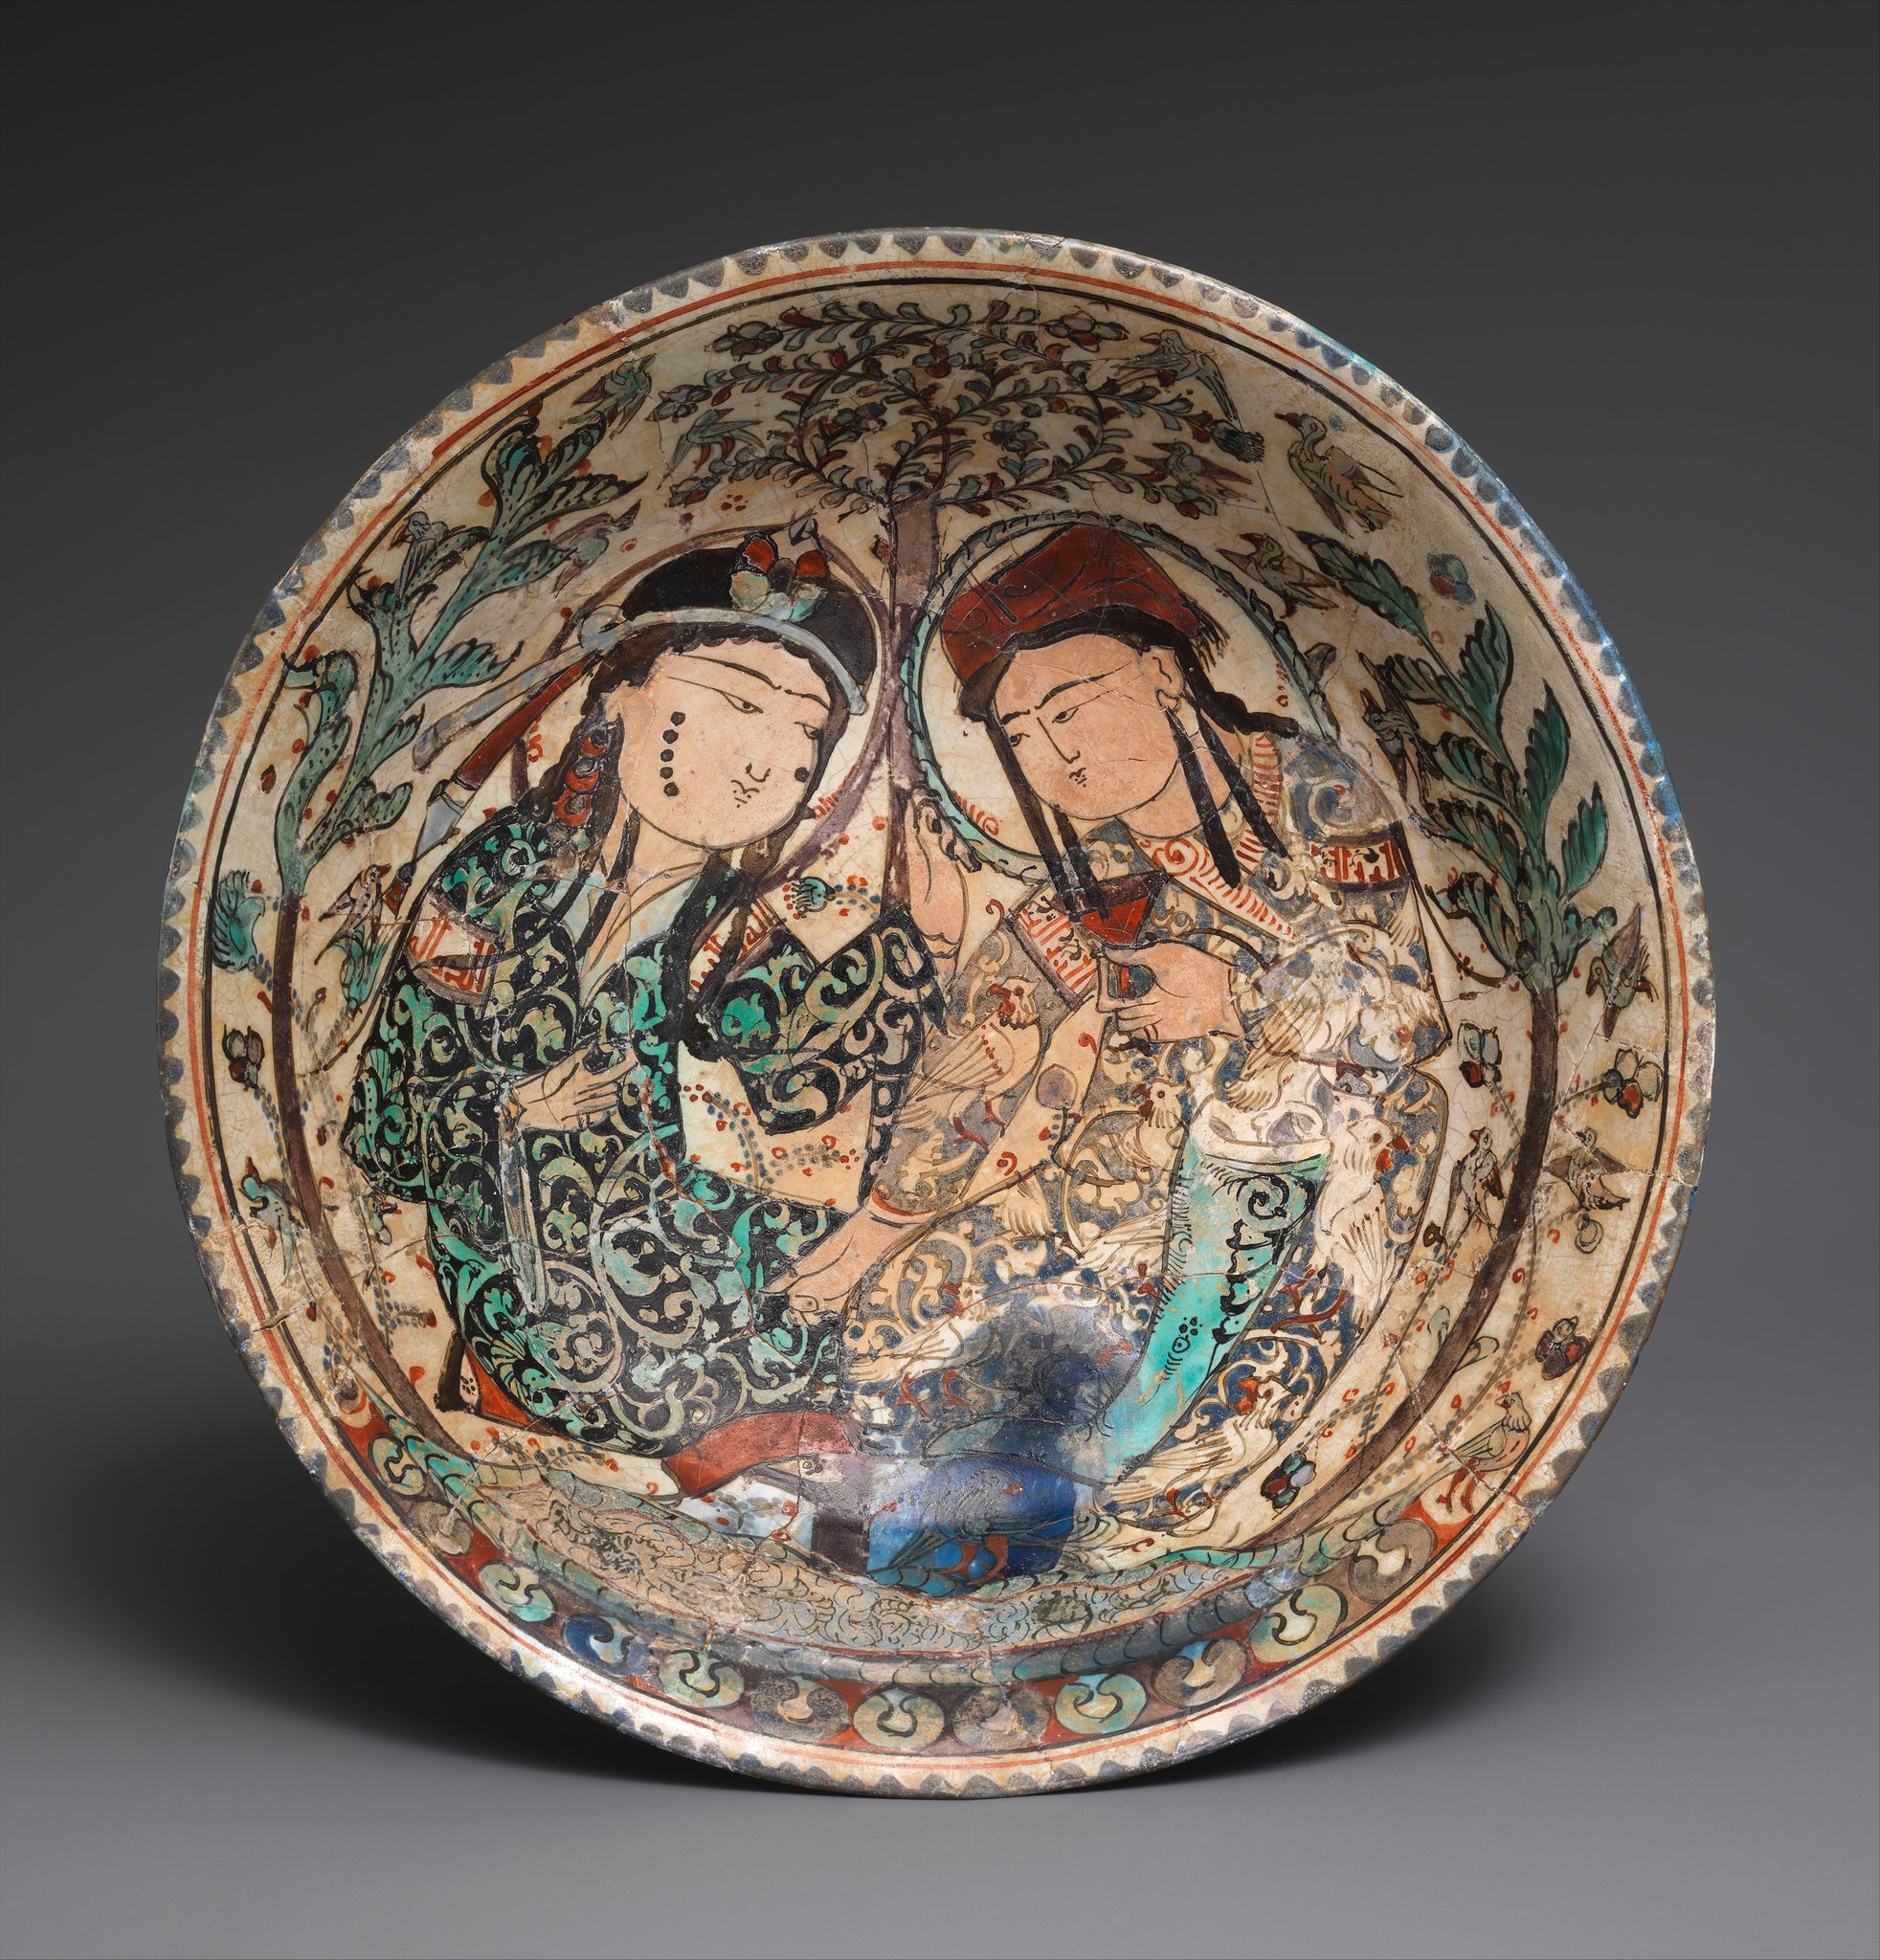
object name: bowl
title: Bowl, Mina'i ("enameled") ware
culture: iranian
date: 1167-1233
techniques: overglaze, painting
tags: men,women